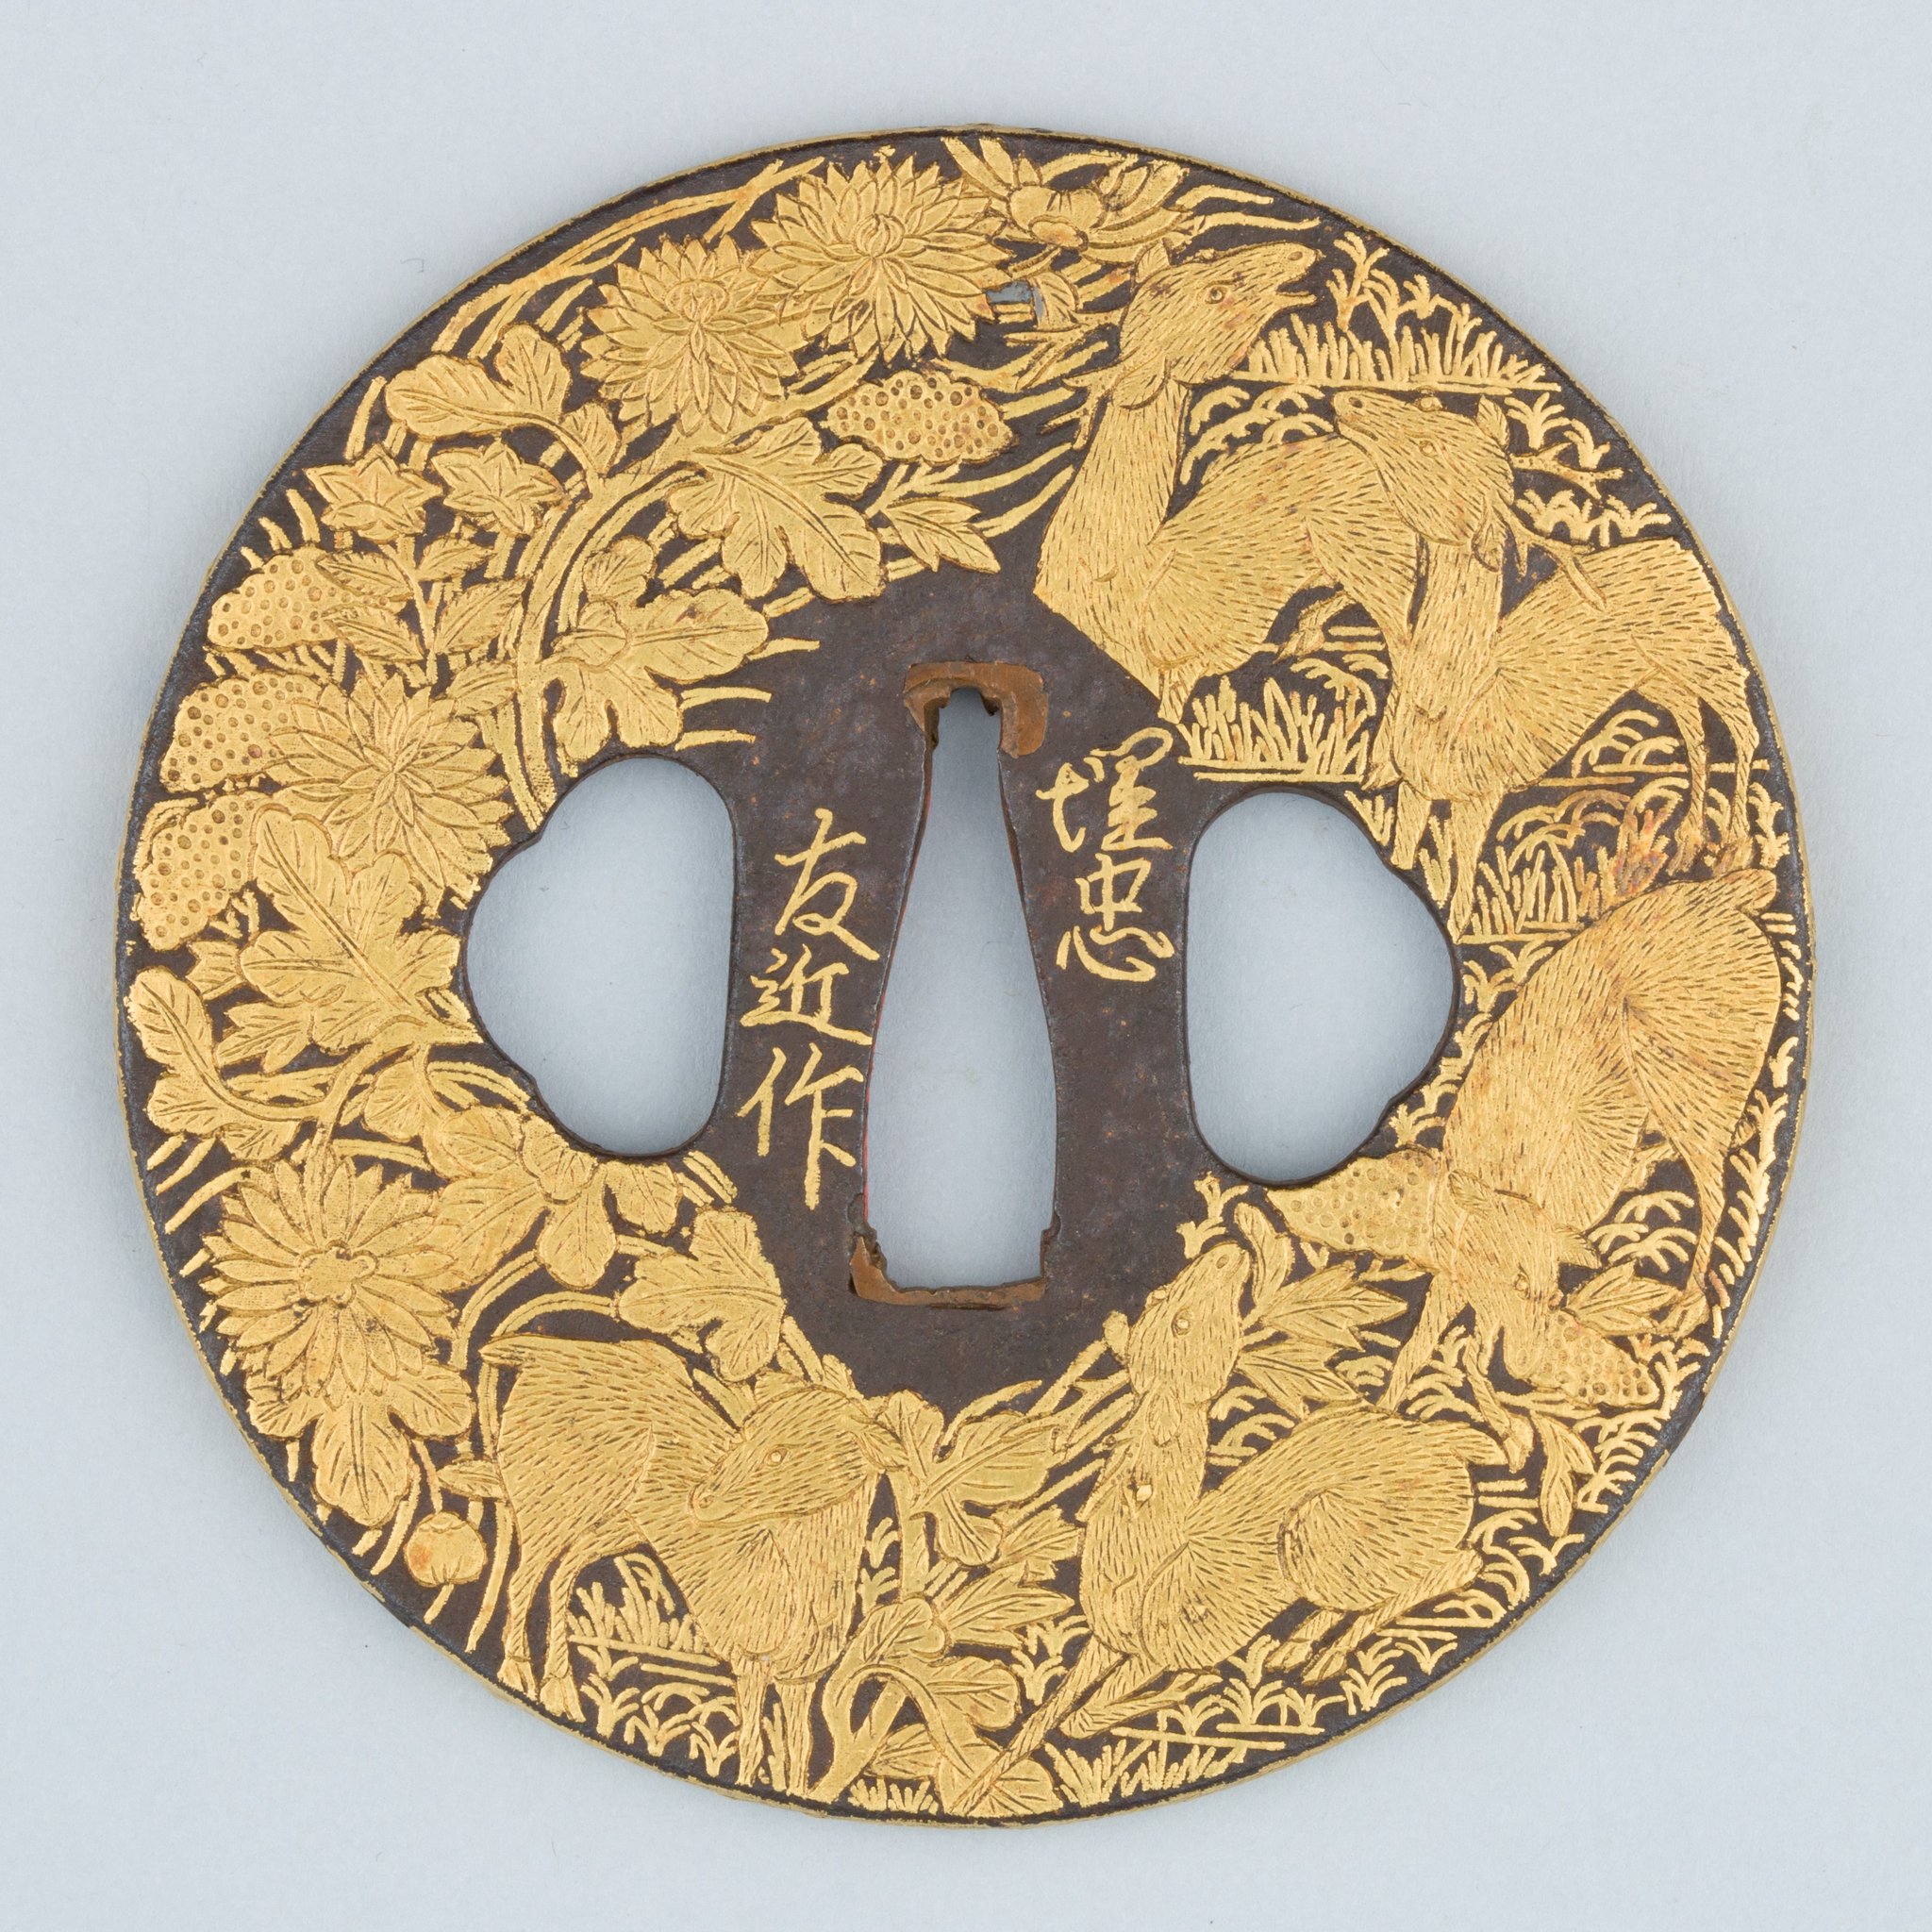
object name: sword guard tsuba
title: Sword Guard (Tsuba)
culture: japanese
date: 1615-1868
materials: copper, gold, iron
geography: japan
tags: deer,flowers